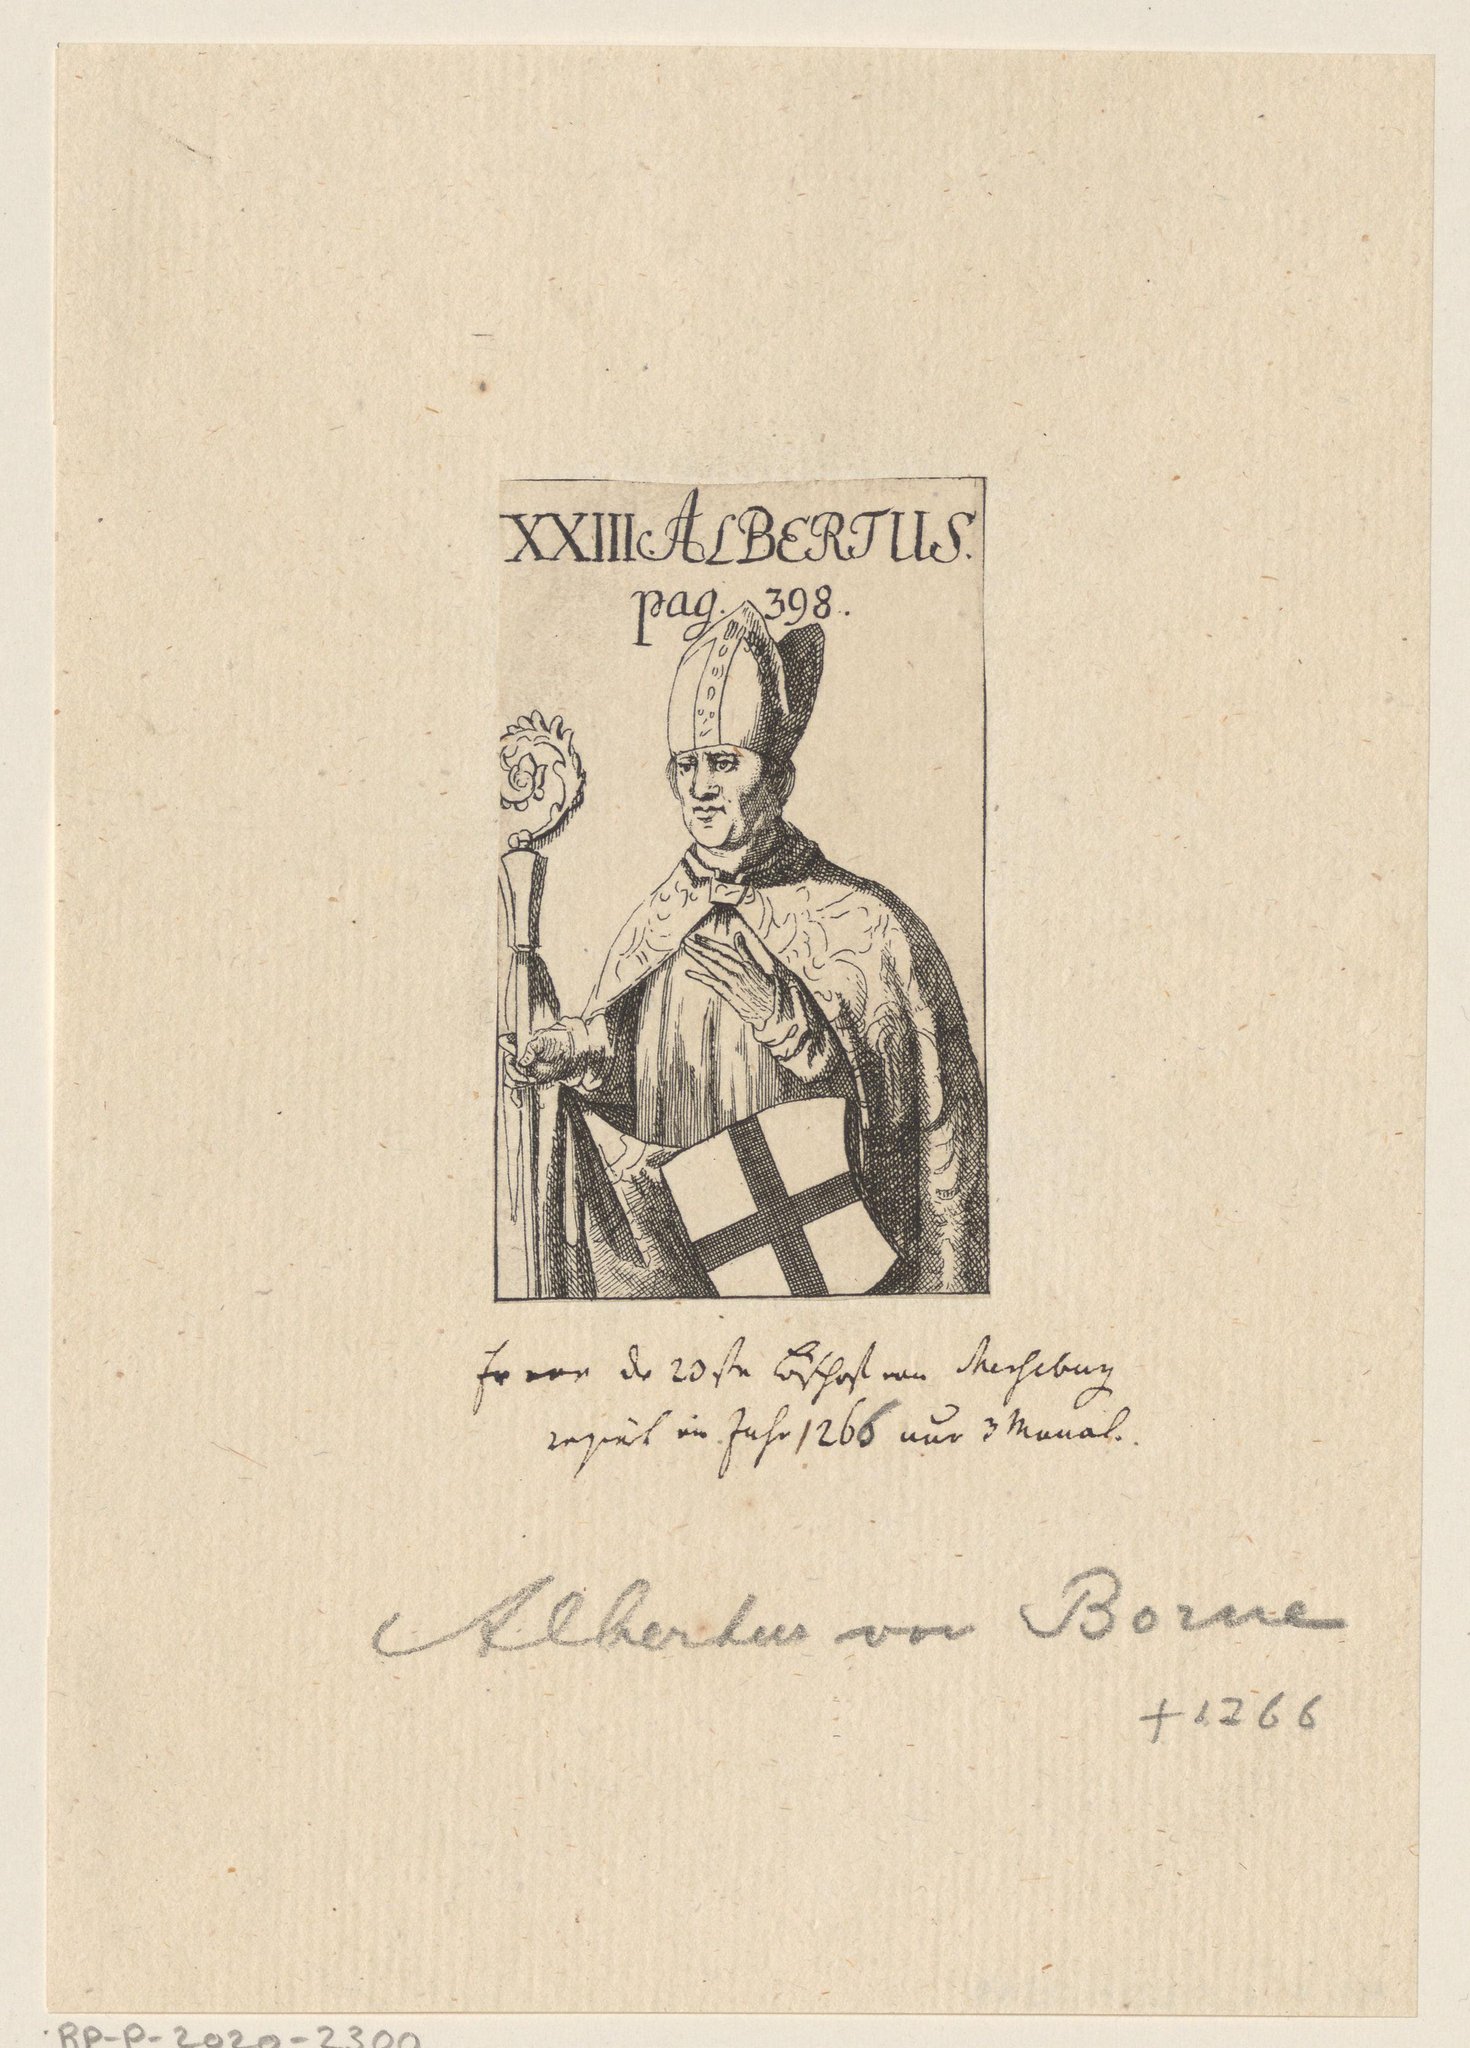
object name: book illustration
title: Portret van Albertus von Borne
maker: Anonymous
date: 1650-1749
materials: paper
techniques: etching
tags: archbishop, bishop, etc. (roman catholic), historical persons, armorial bearing, heraldry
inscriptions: inscription: ‘[...] de 23ste bischof von Mersburg (...)’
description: Midden boven het portret genummerd: pag. 398.